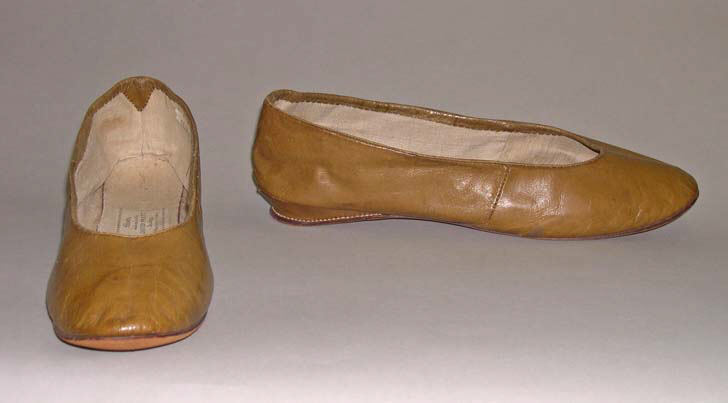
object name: slipper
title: Slippers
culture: american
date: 1812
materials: leather